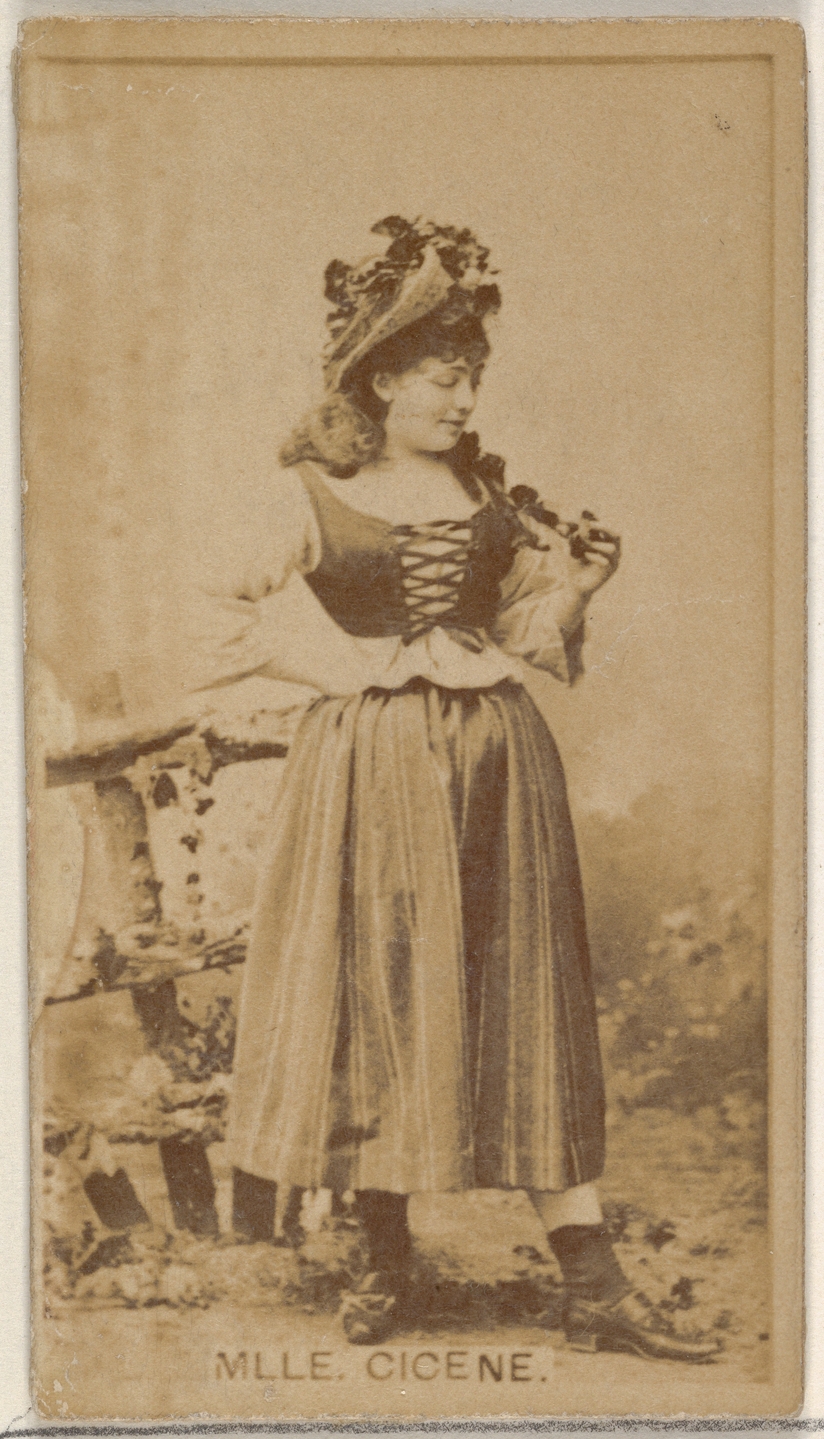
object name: photograph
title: Mlle. Cicene, from the Actors and Actresses series (N45, Type 8) for Virginia Brights Cigarettes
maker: allen & ginter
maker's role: publisher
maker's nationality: american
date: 1888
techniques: albumen silver print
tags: portraits,women,actresses